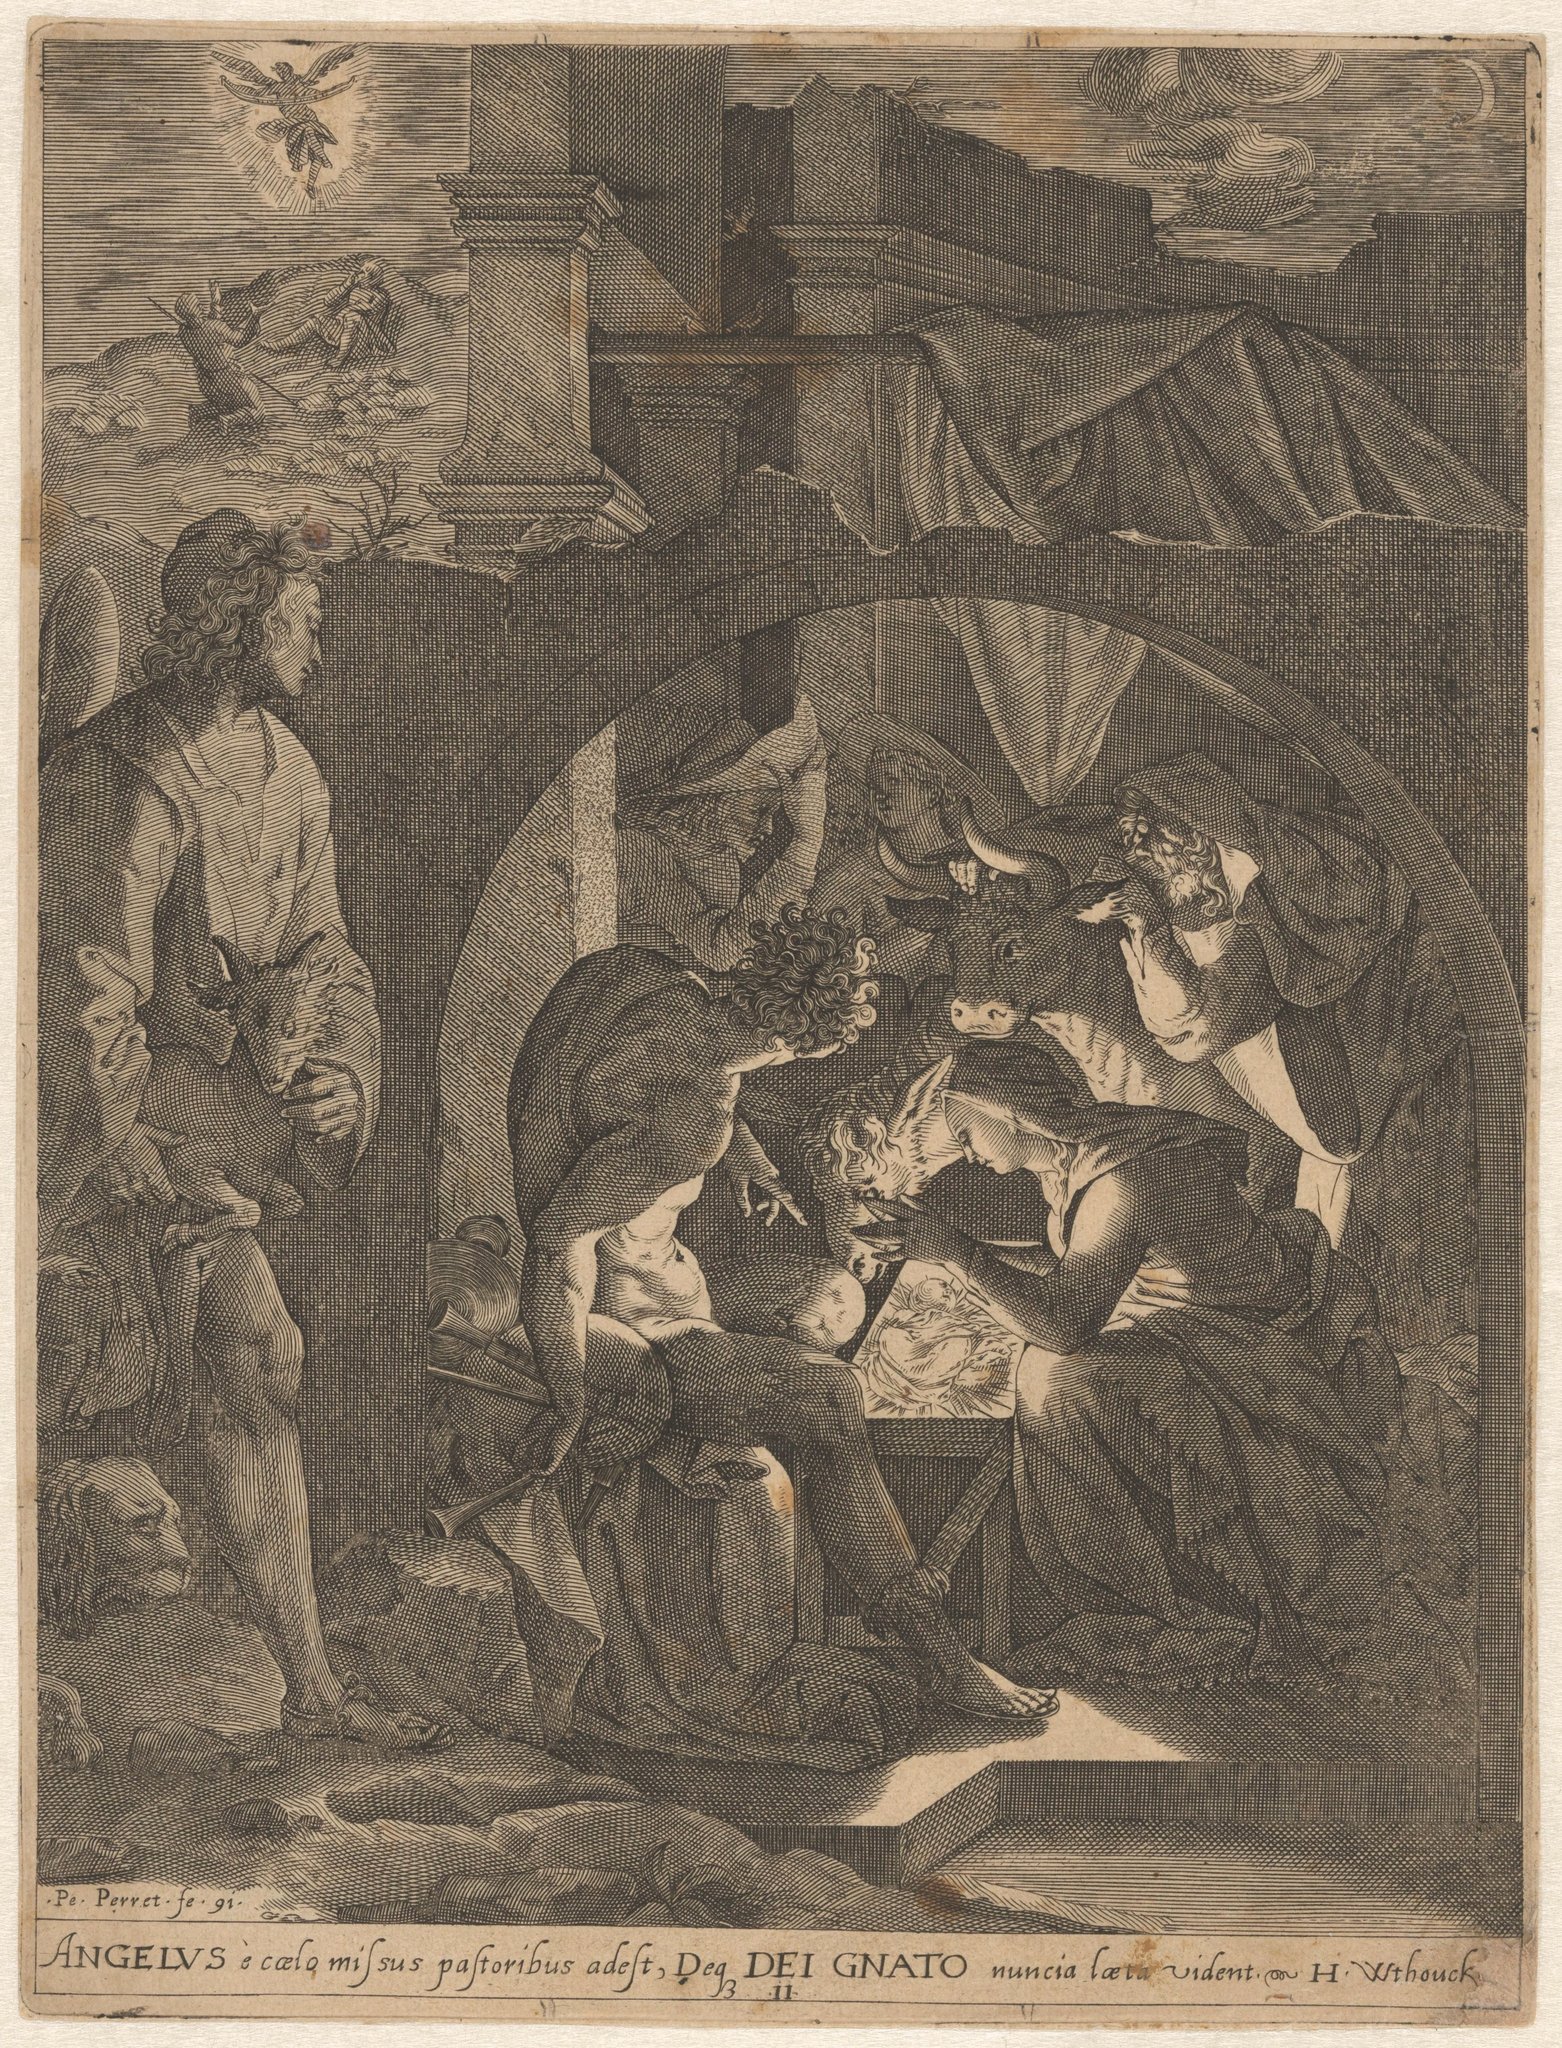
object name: print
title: De aanbidding der herders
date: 1591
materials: paper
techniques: engraving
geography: antwerp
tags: adoration of the christ-child by the shepherds; mary and joseph present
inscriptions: collector's mark: Lugt 2760, collector's mark: Lugt 2228